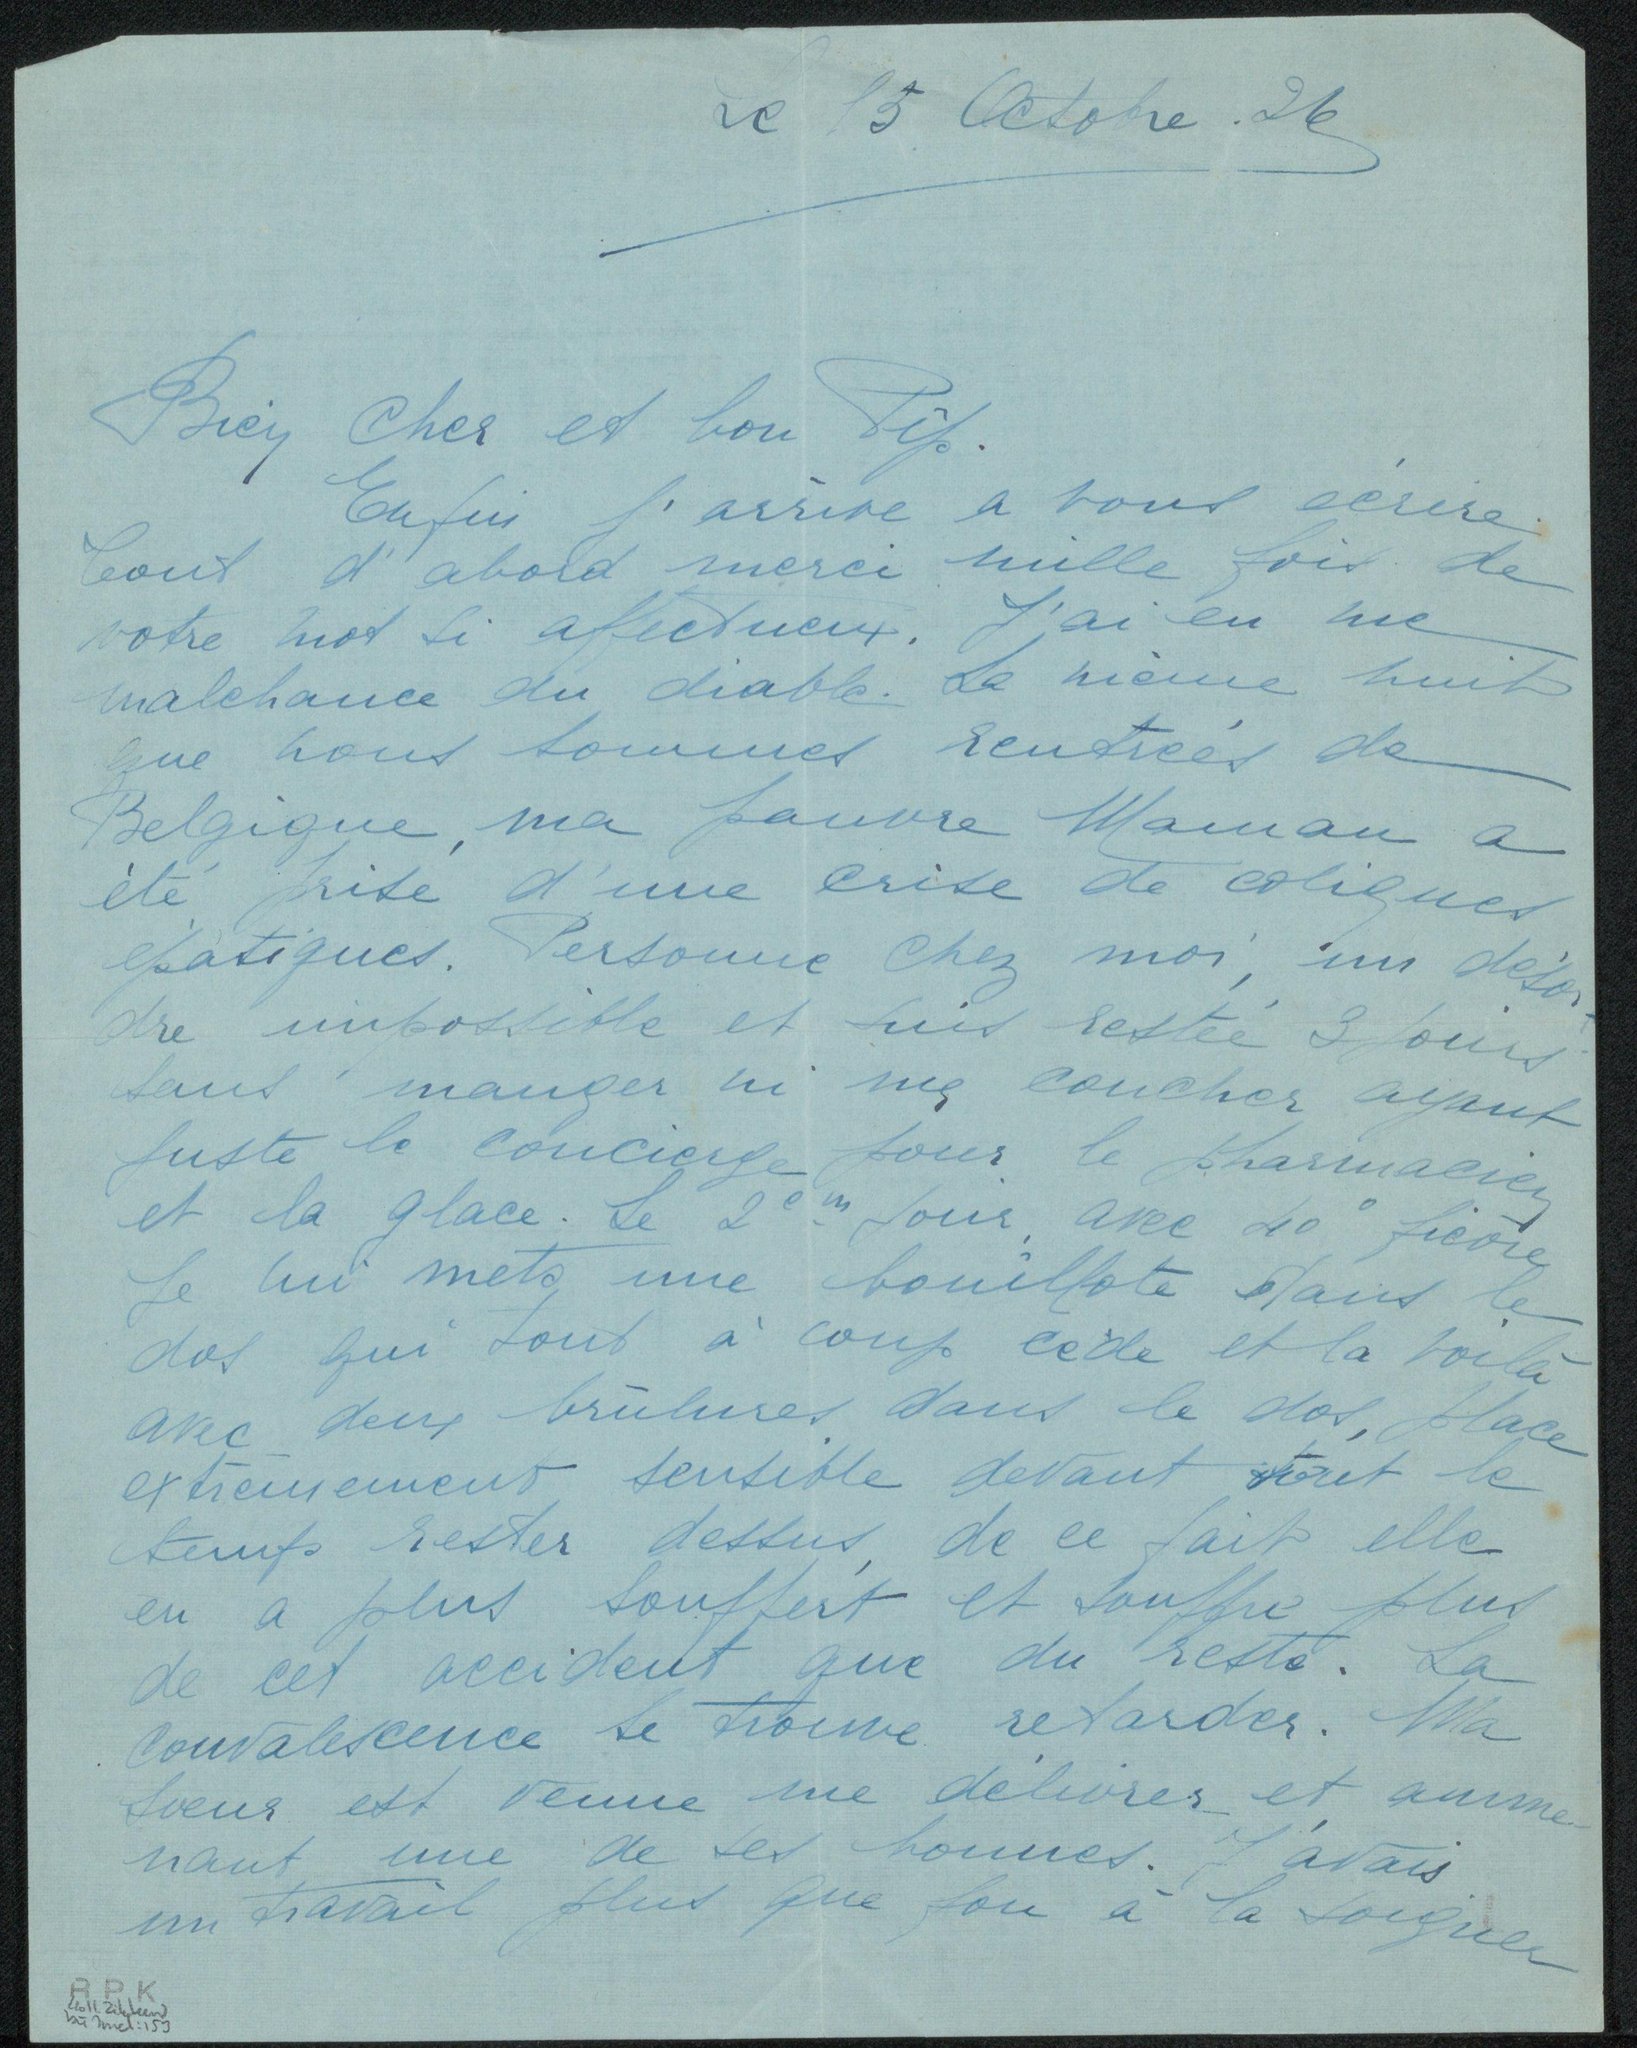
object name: letter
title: Brief aan Philip Zilcken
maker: rose imel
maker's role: draughtsman, painter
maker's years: 1901-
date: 1926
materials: ink, paper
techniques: pen, writing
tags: the hague, philip zilcken, photography, cinematography, painting (including book-illumination, miniature-painting), workshop, studio of the artist (in general), belgium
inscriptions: collector's mark: ‘RPK’